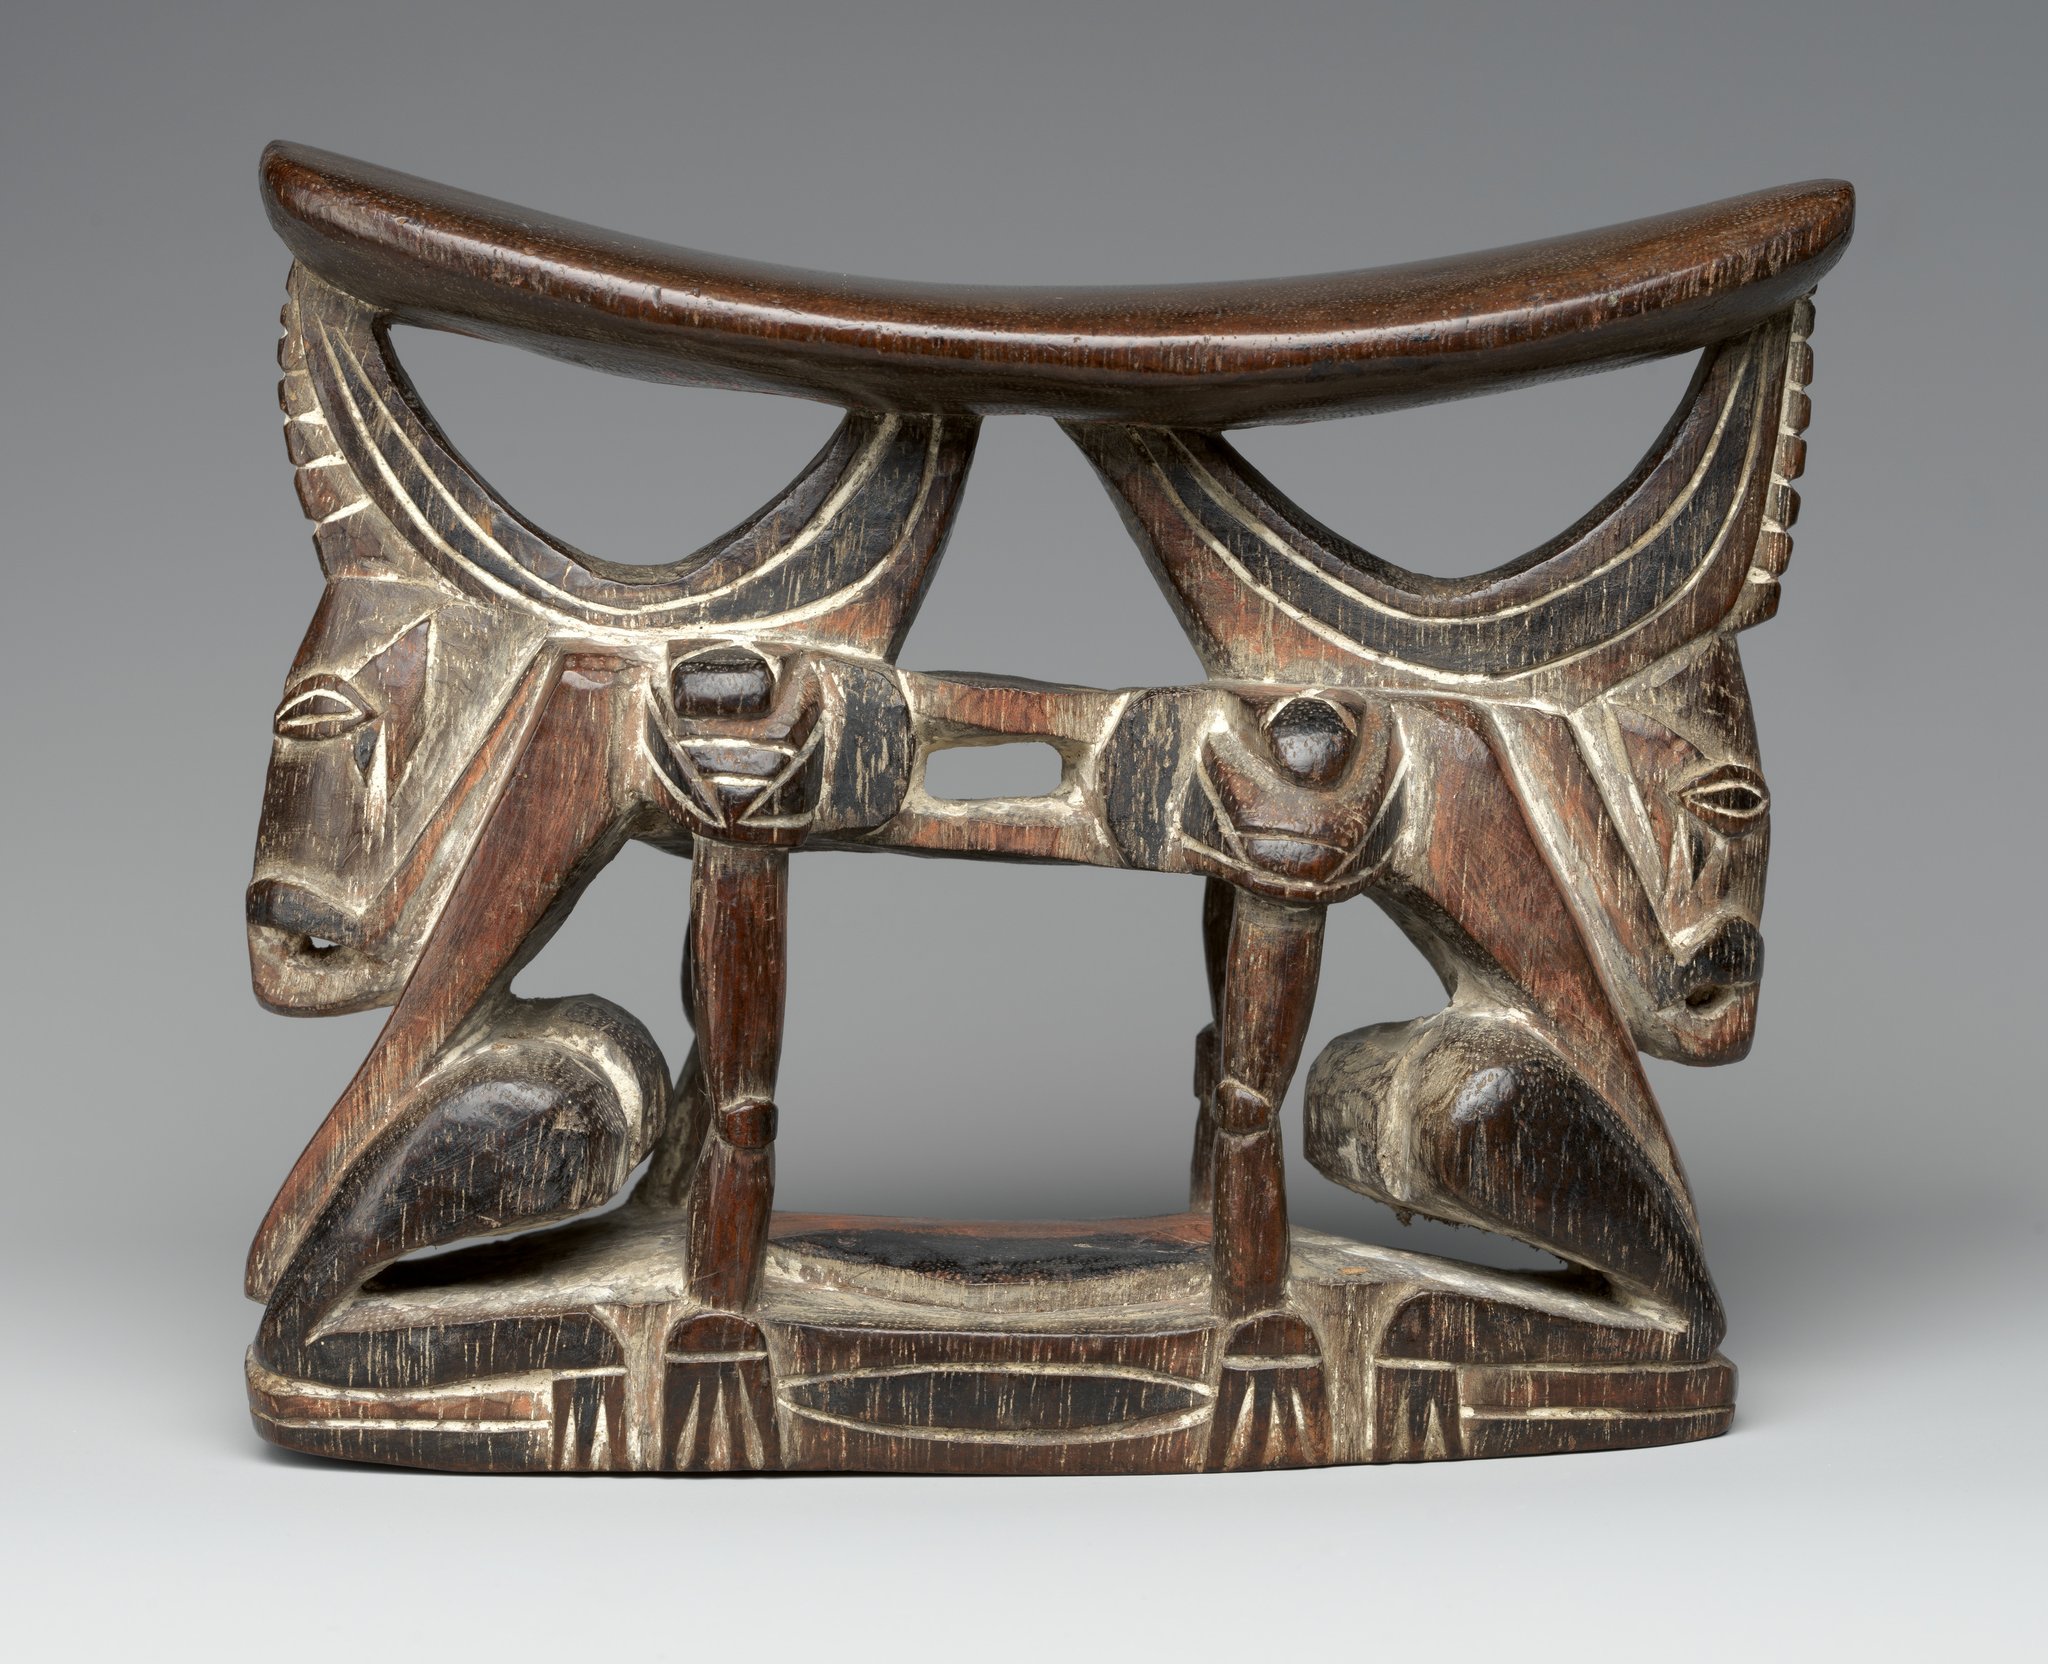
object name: headrest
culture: tami islands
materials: wood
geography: papua new guinea